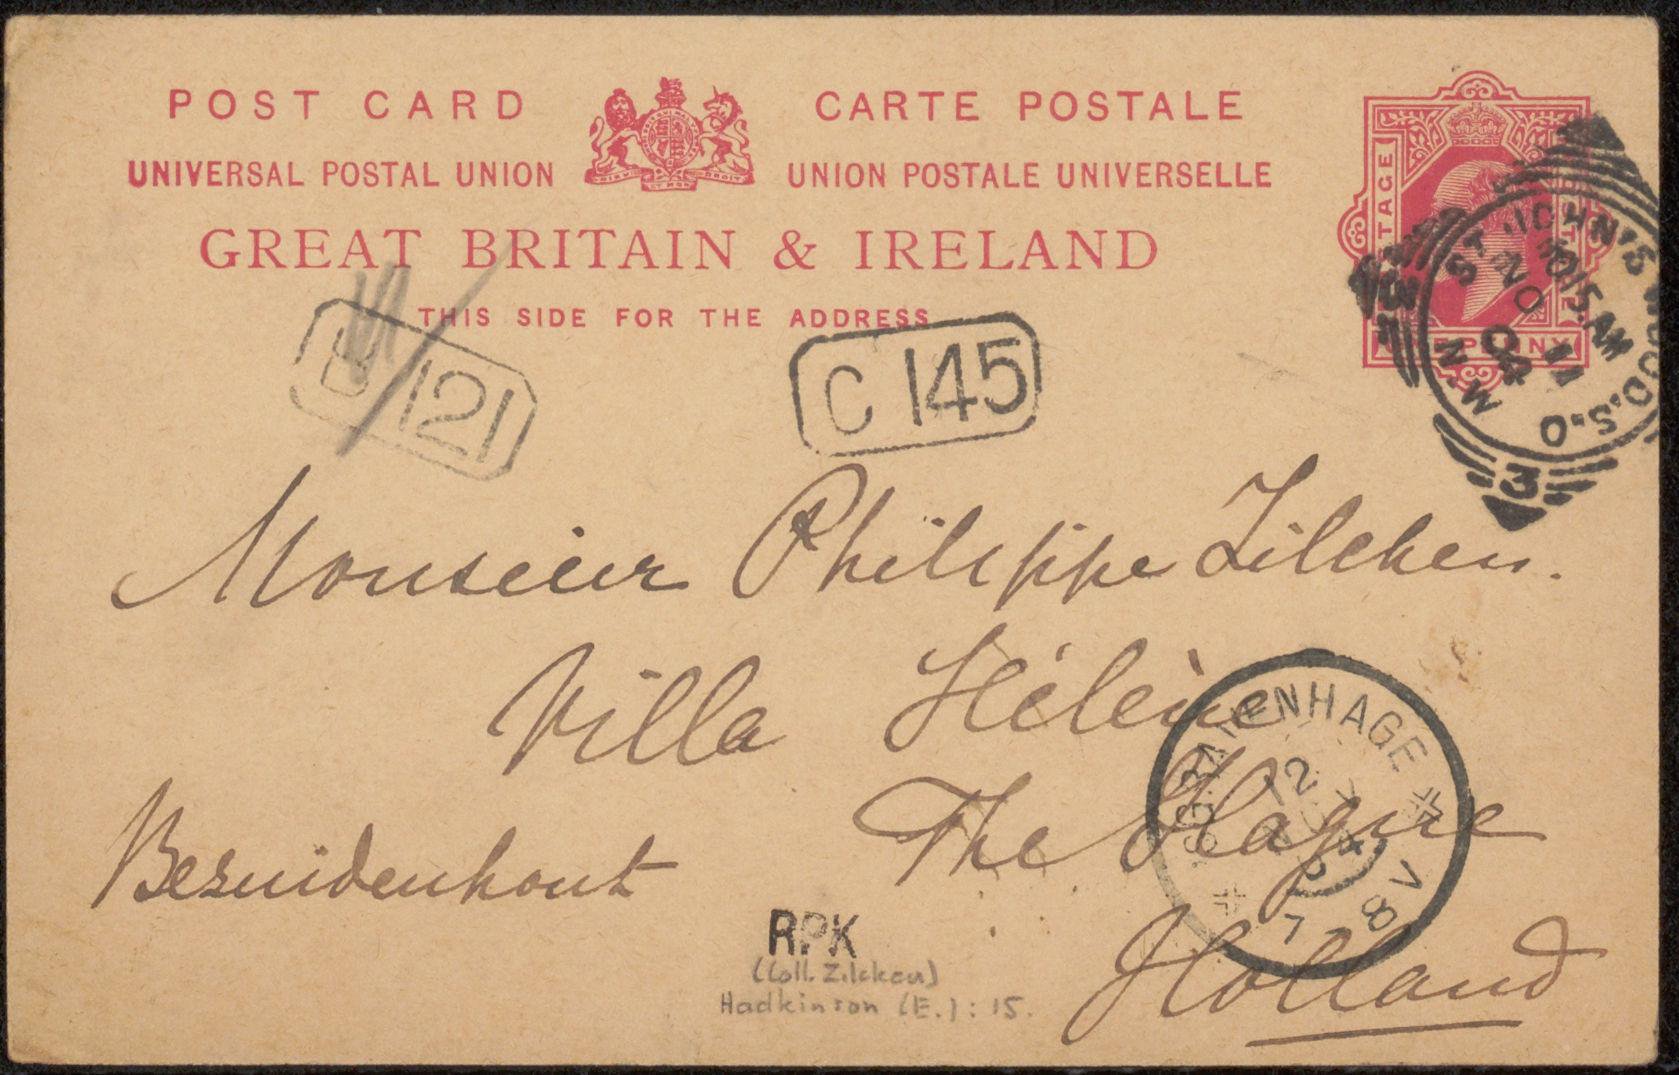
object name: postcard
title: Briefkaart aan Philip Zilcken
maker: ernestine hadkinson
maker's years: 1863-1928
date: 1904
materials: cardboard, ink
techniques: pen, writing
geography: stonehouse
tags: the hague, painter, draughtsman, philip zilcken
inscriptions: collector's mark: ‘RPK’